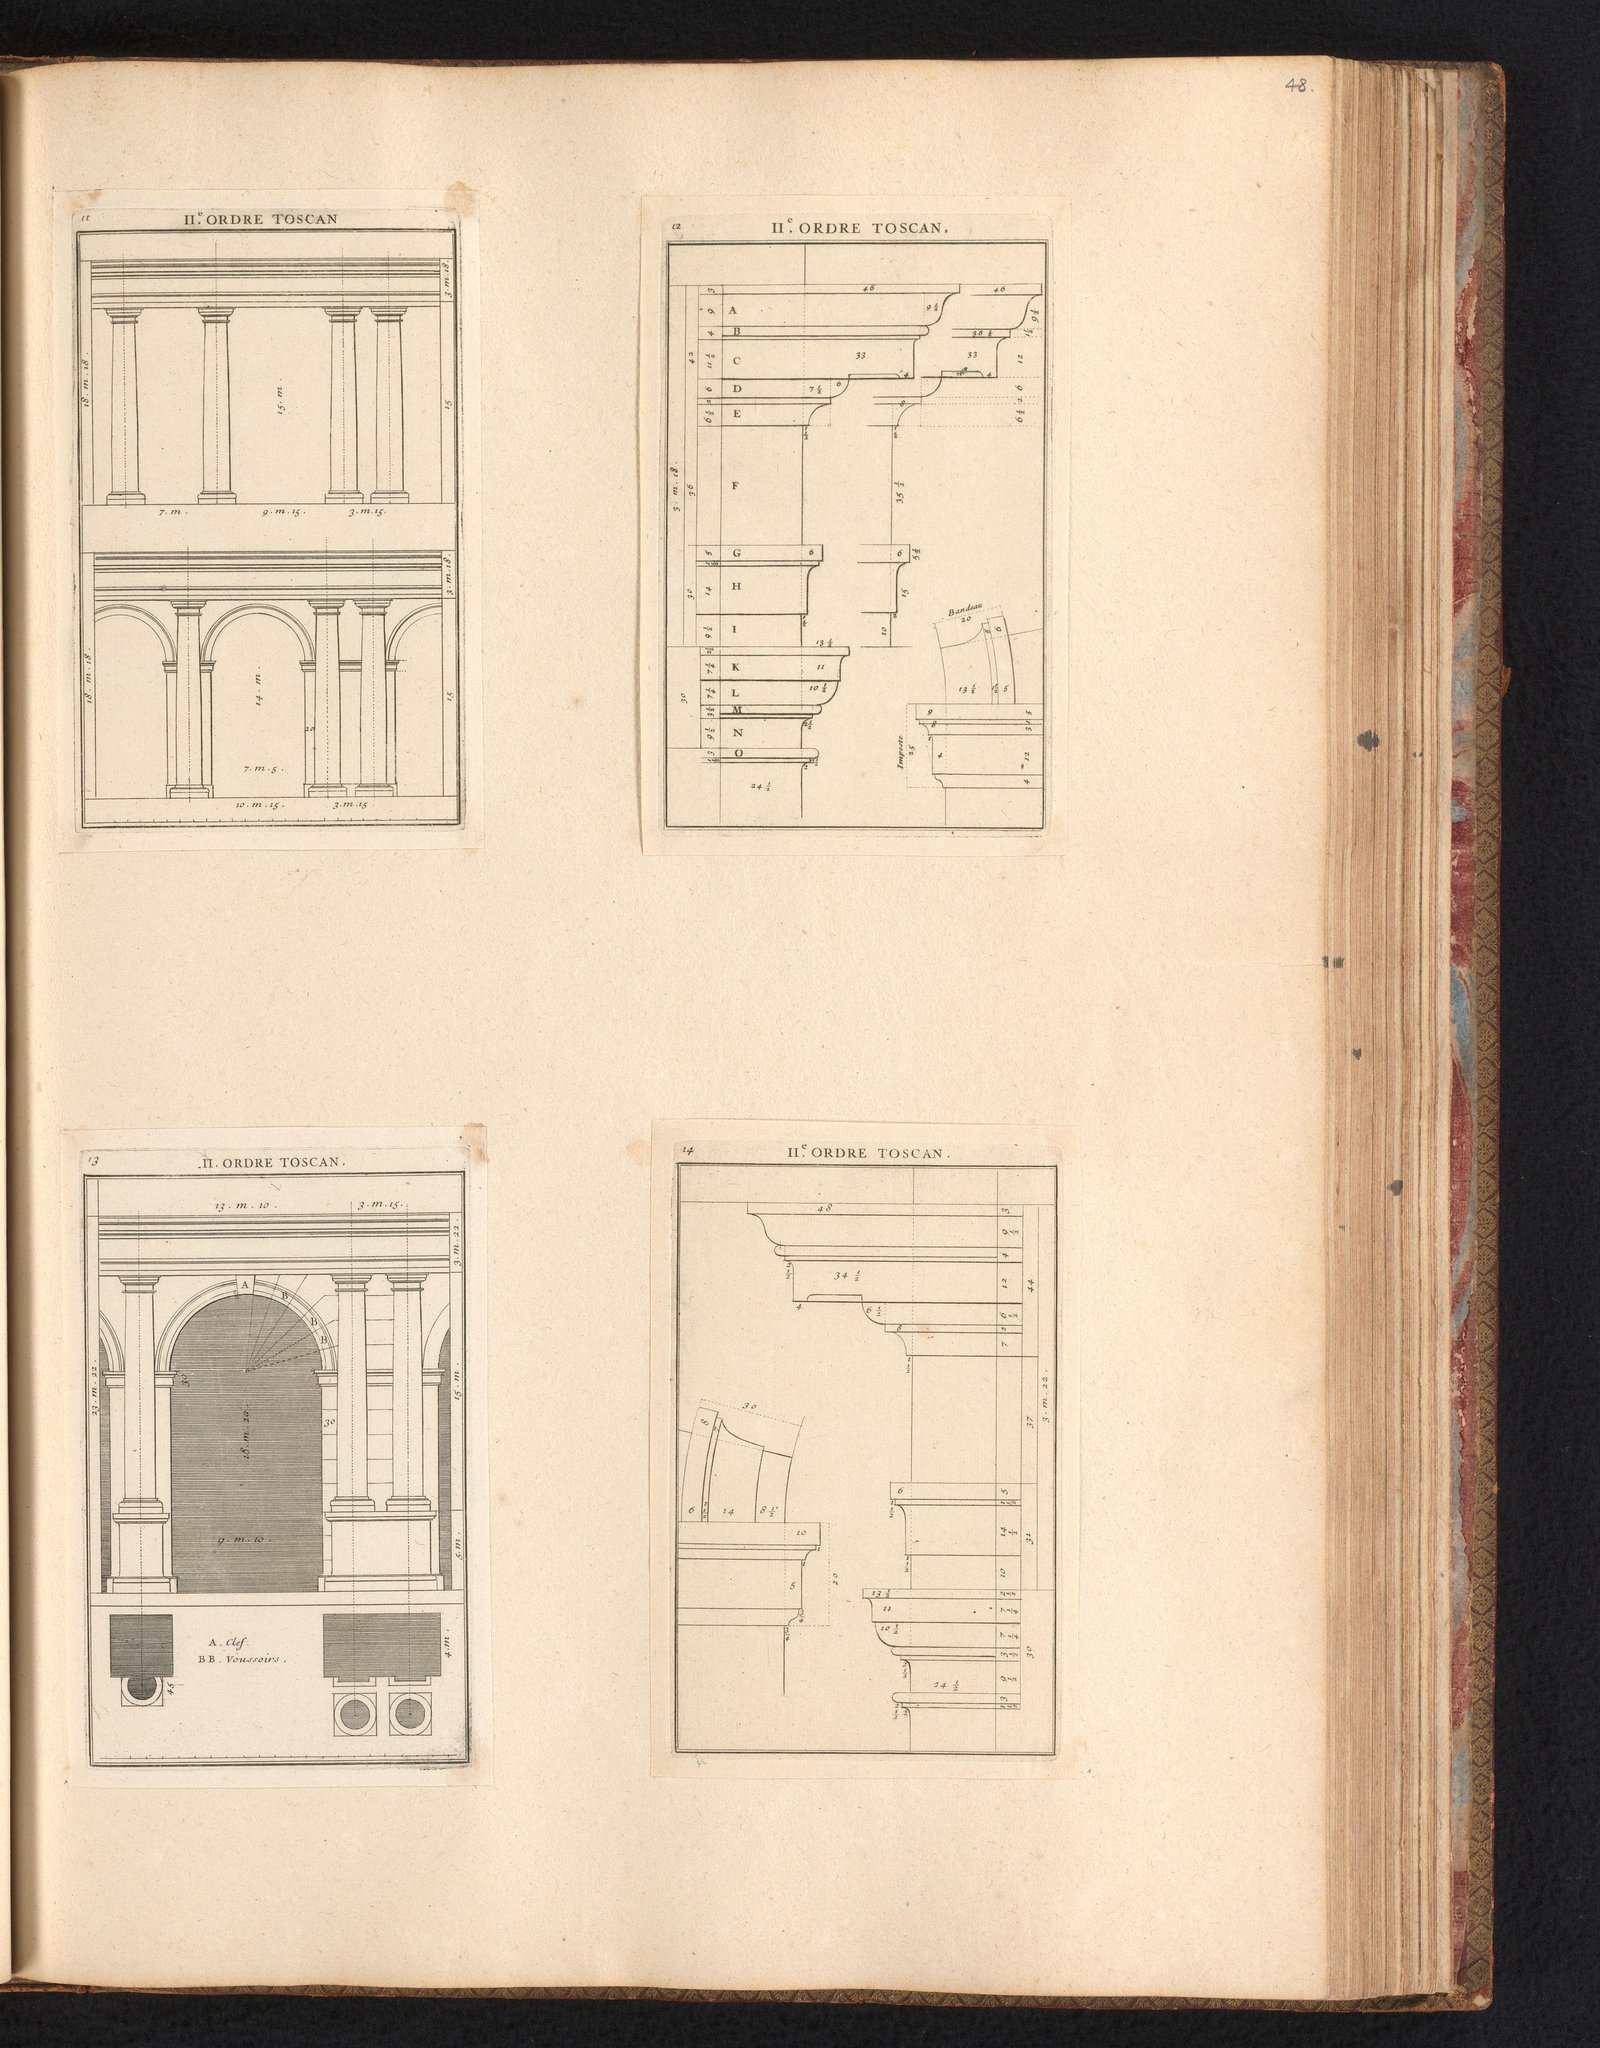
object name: book illustration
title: Zuilen van de Toscaanse orde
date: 1714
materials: paper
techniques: etching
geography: paris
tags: tuscan order ~ architecture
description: Prenten uit: Leclerc, Sébastien (I). Traité d'architecture. Parijs: Pierre François Giffart, 1714.